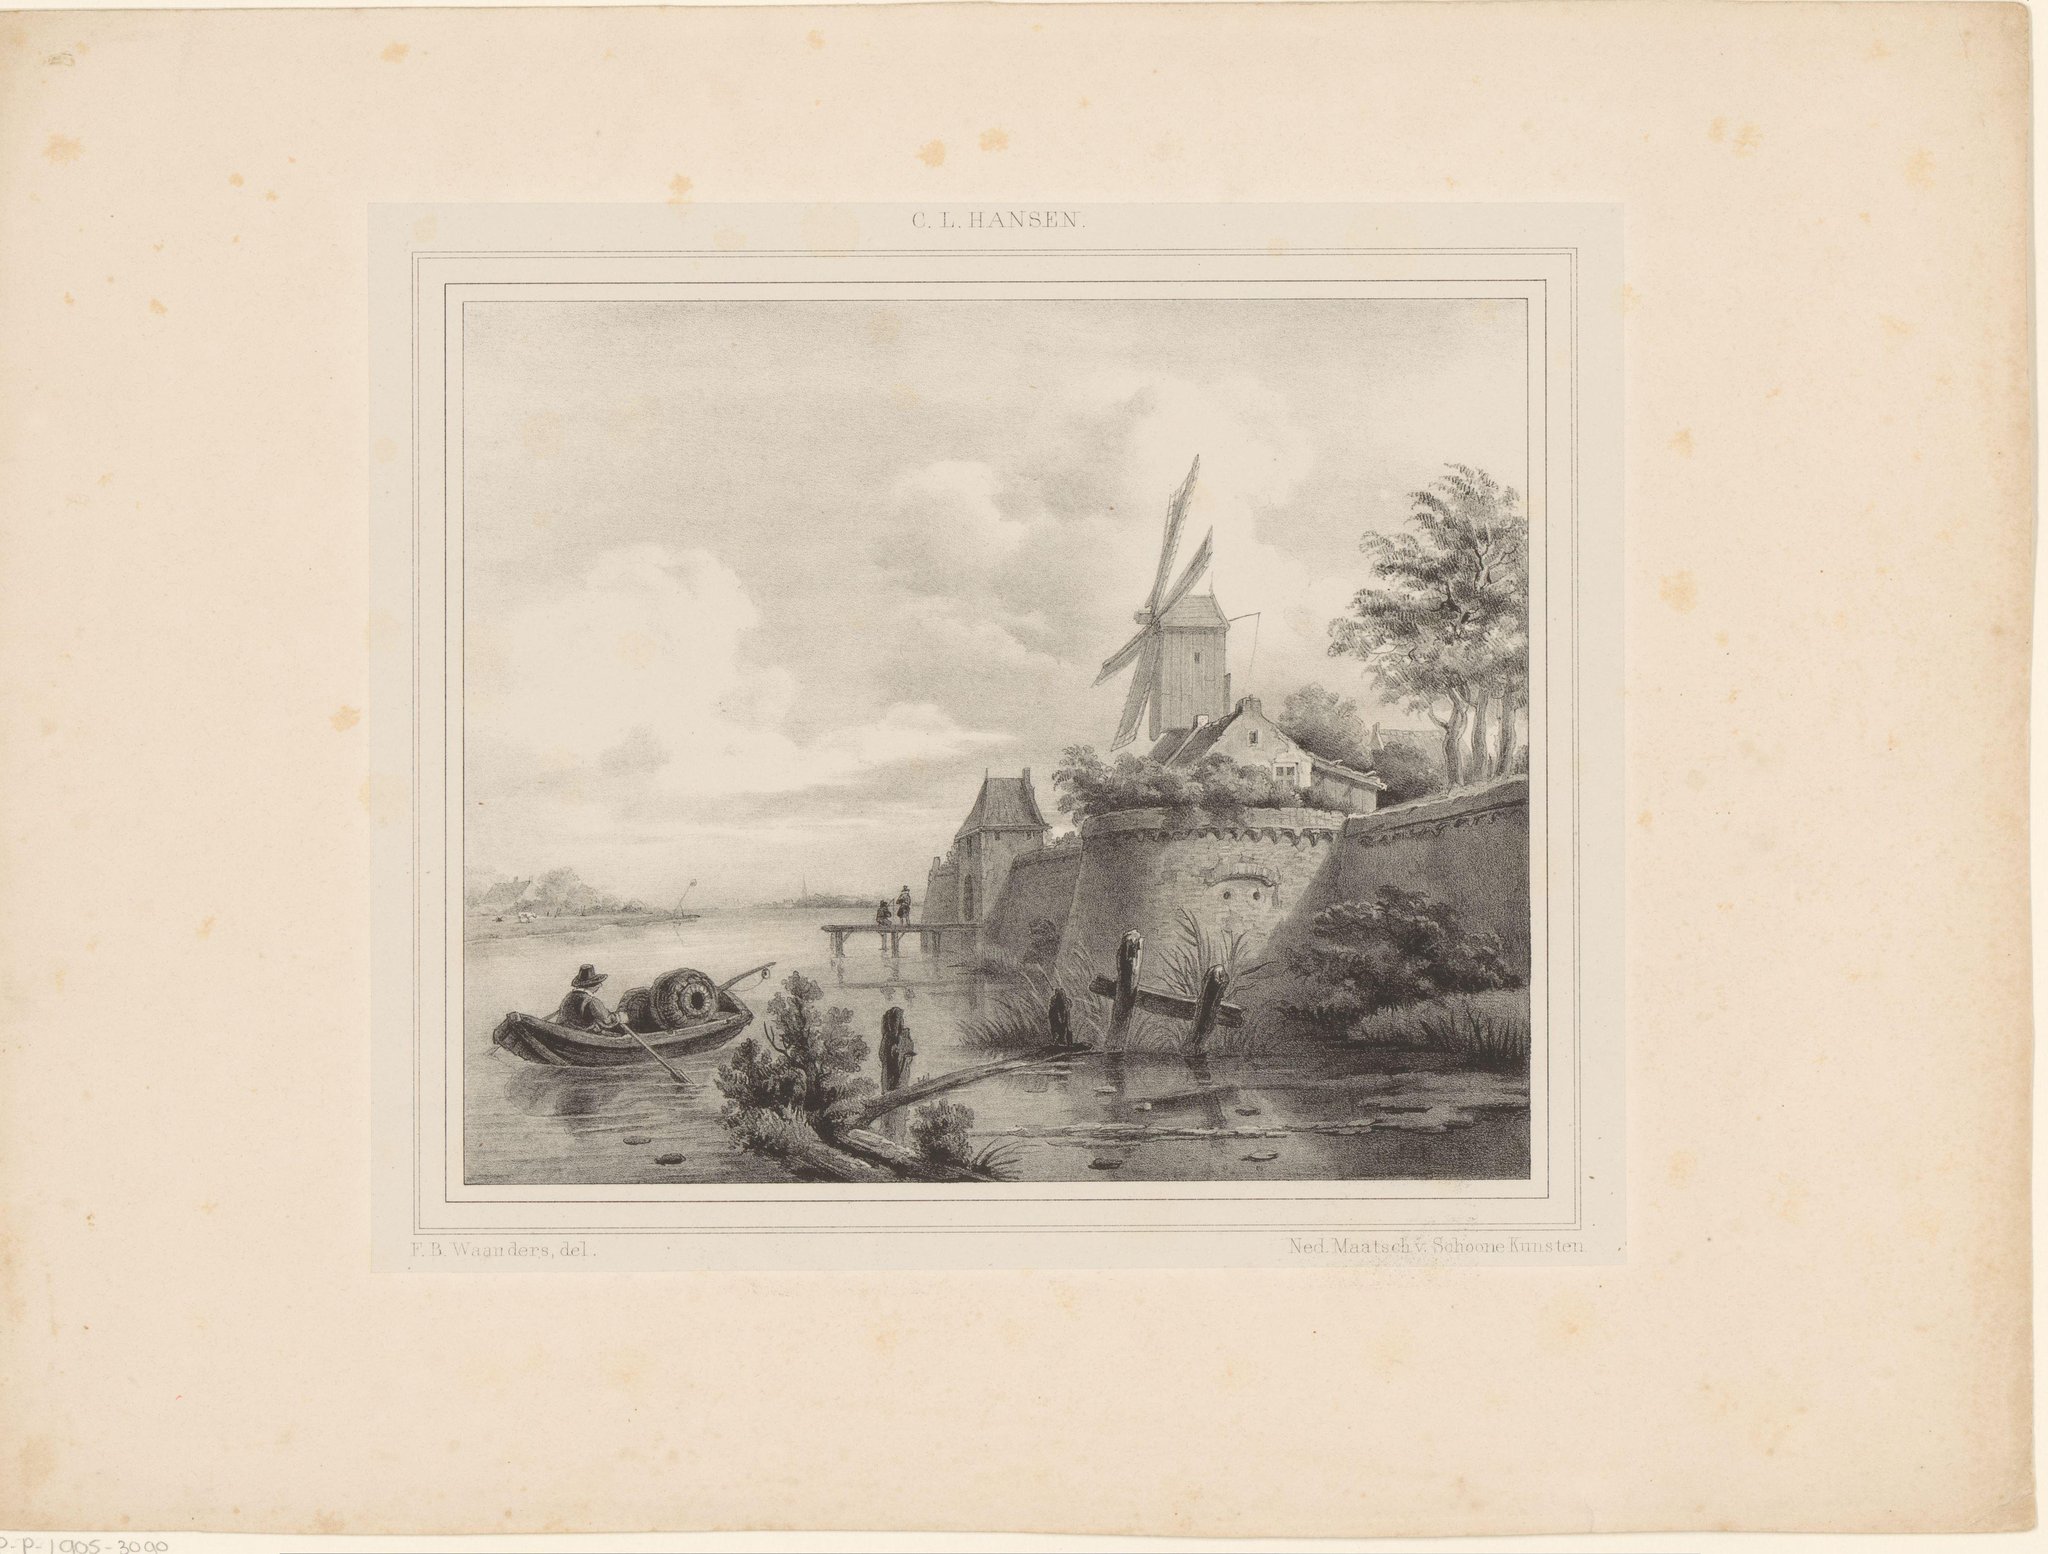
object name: print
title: Riviergezicht met molen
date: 1842-1843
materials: paper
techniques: lithograph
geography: the hague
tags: river, windmill in landscape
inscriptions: collector's mark: Lugt 2228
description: Een man vaart in een roeiboot over een rivier langs een stadsmuur waarbij rechts een huis en molen.